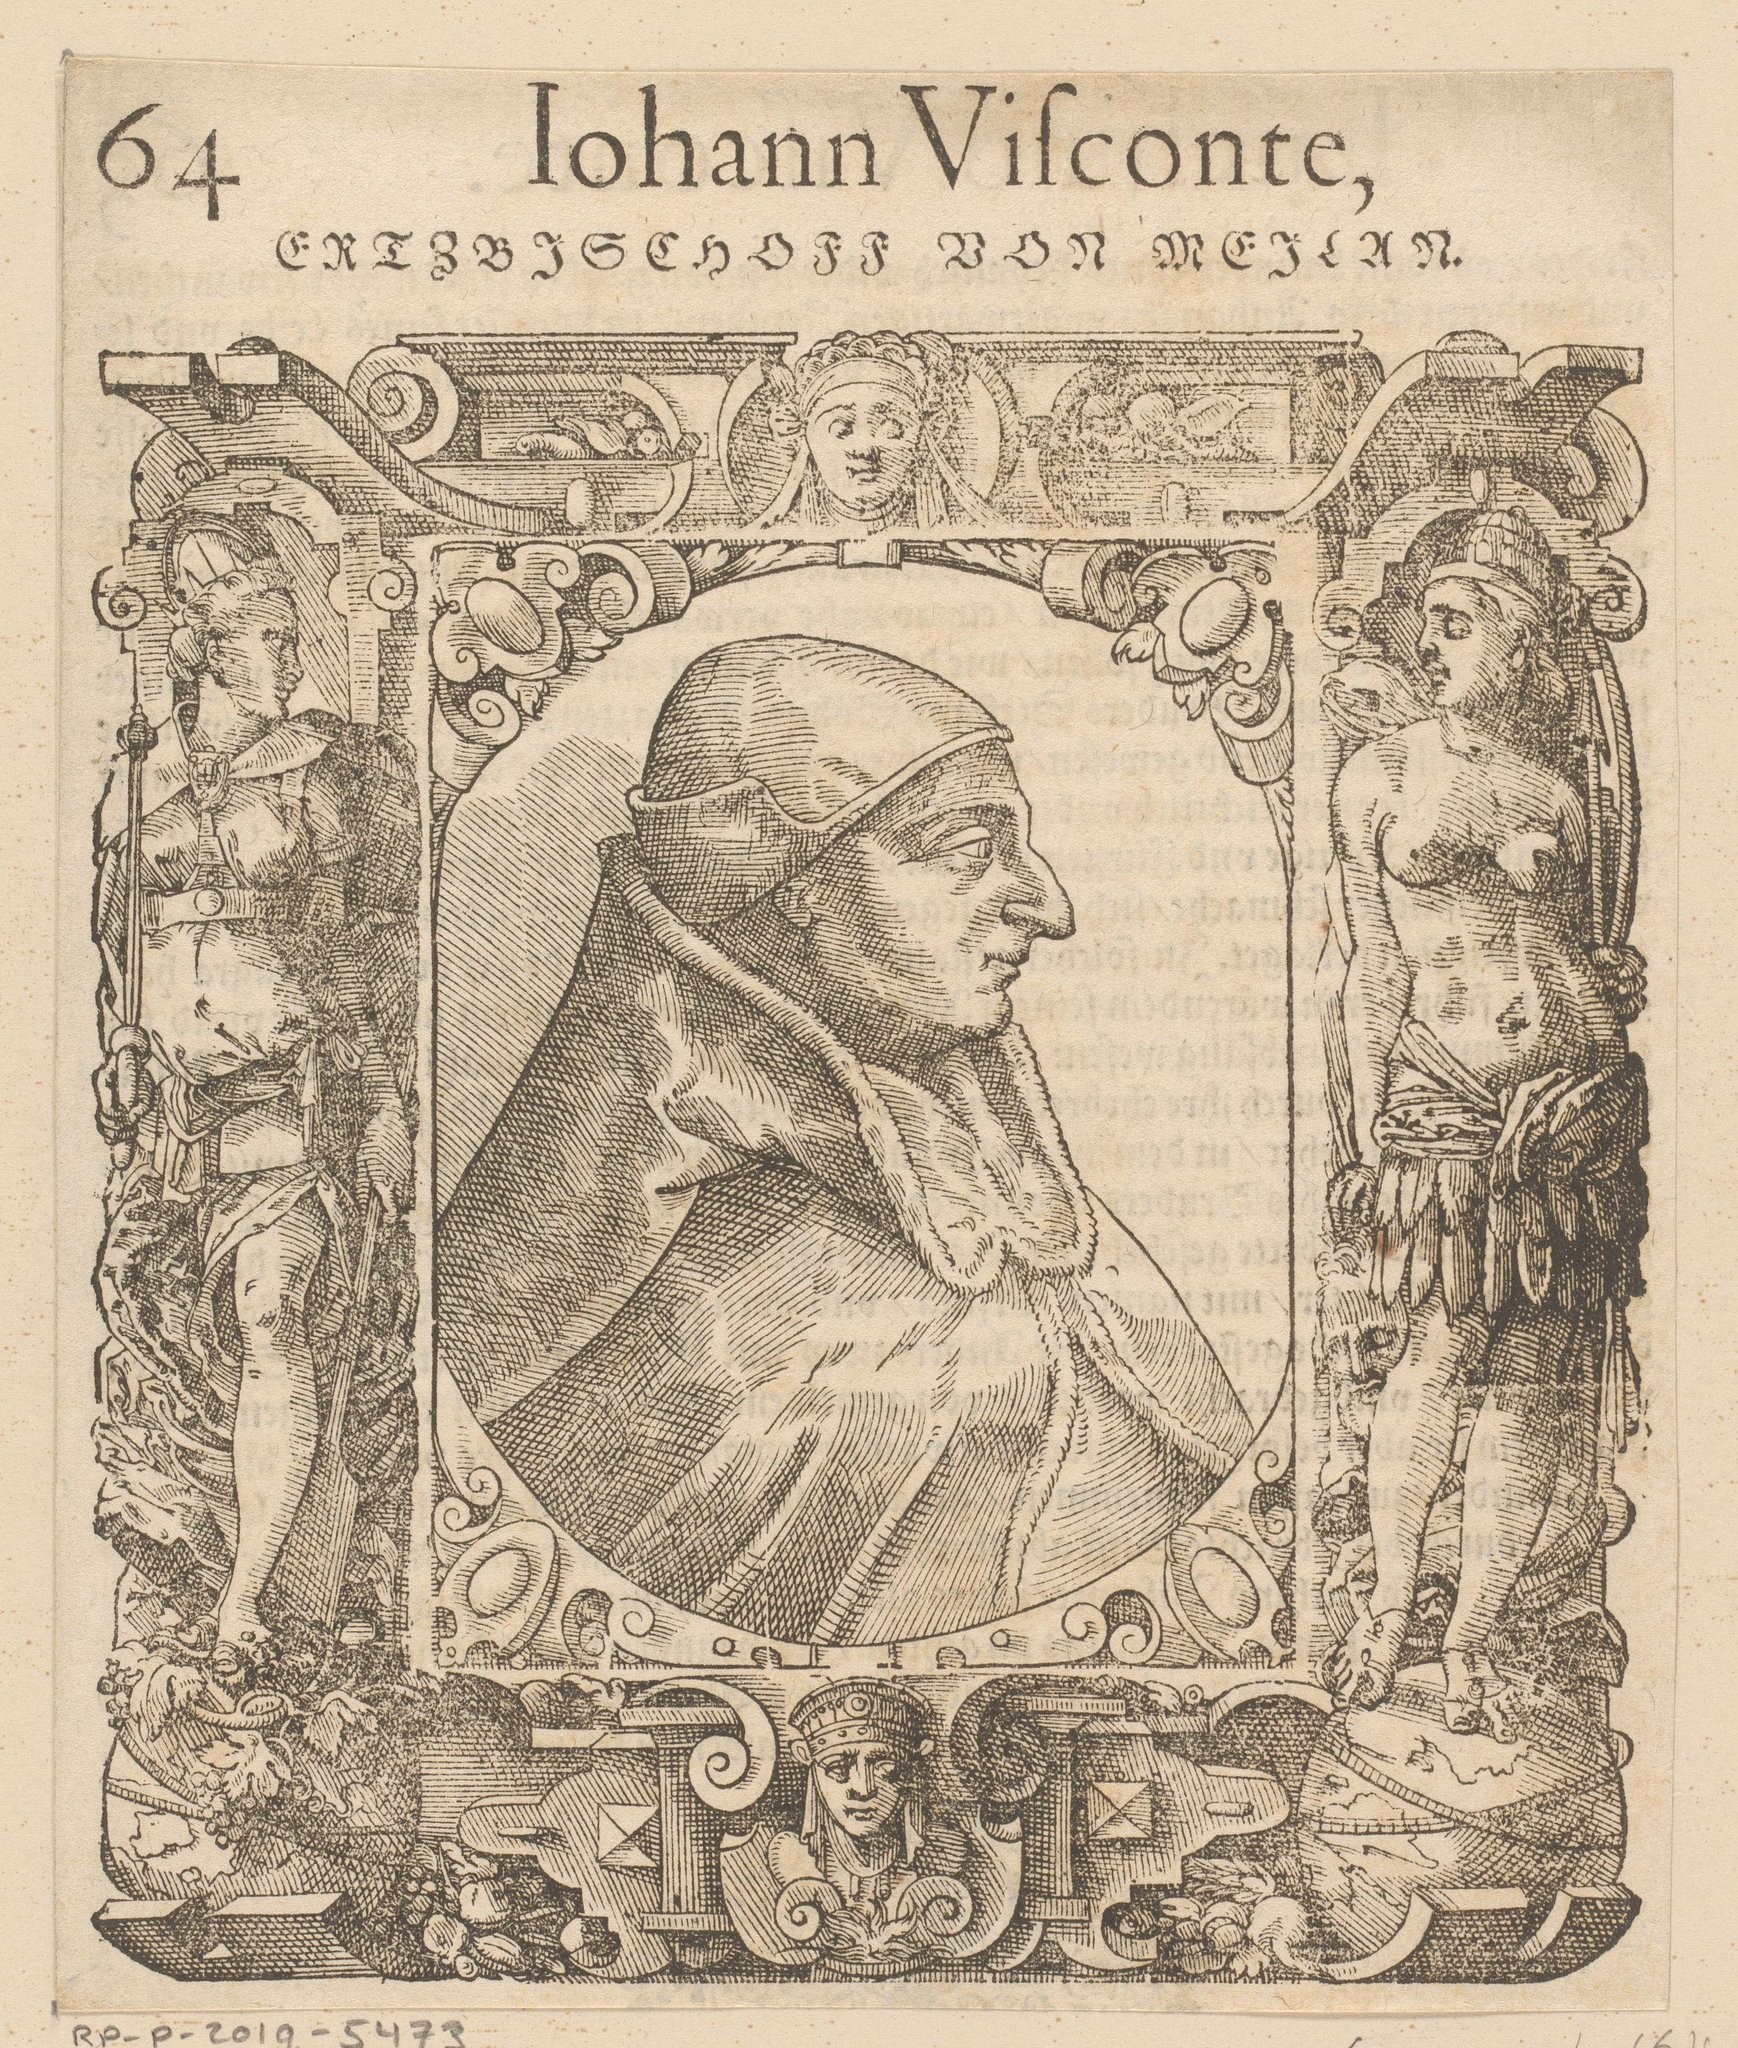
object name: book illustration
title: Portret van Giovanni Visconti, aartsbisschop van Milaan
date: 1587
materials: paper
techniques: letterpress printing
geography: basel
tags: archbishop, bishop, etc. (roman catholic), historical persons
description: Prent uit: Warhafftiger kurtzer Bericht von mannigerley Kriegs und anderen fürnemen (...). Bazel: Konrad Waldkirch, 1587, p. 64. Prent eerder verschenen in: Giovio, Paolo. Elogia virorum bellica virtute illustrium (...). Bazel: Peter Perna, 1575. Prent mogelijk ook gebruikt in latere publicaties.